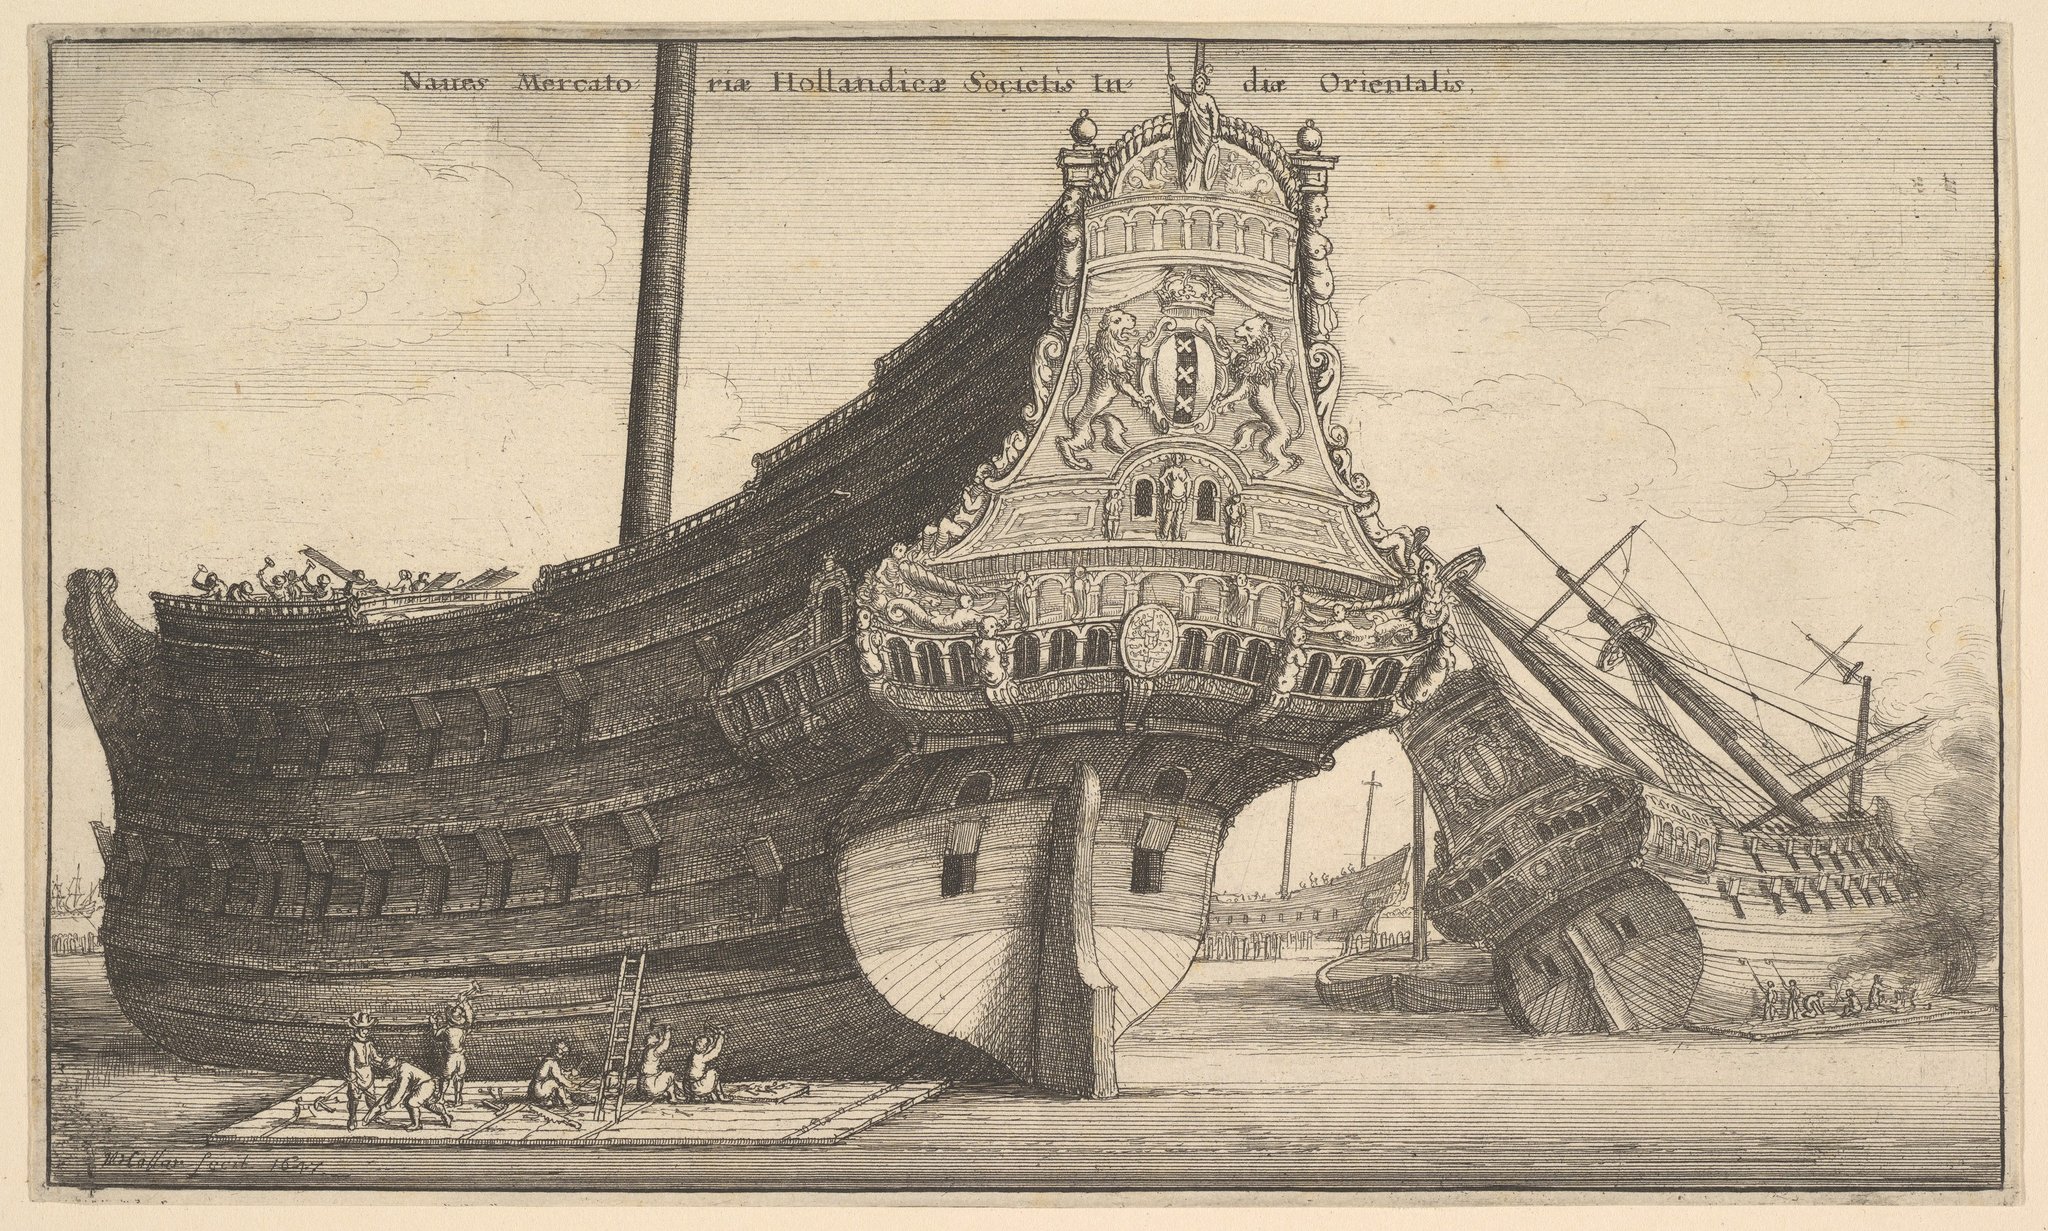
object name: print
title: Dutch East Indiaman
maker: wenceslaus hollar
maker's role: artist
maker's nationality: bohemian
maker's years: 1607-1677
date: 1647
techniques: etching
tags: ships